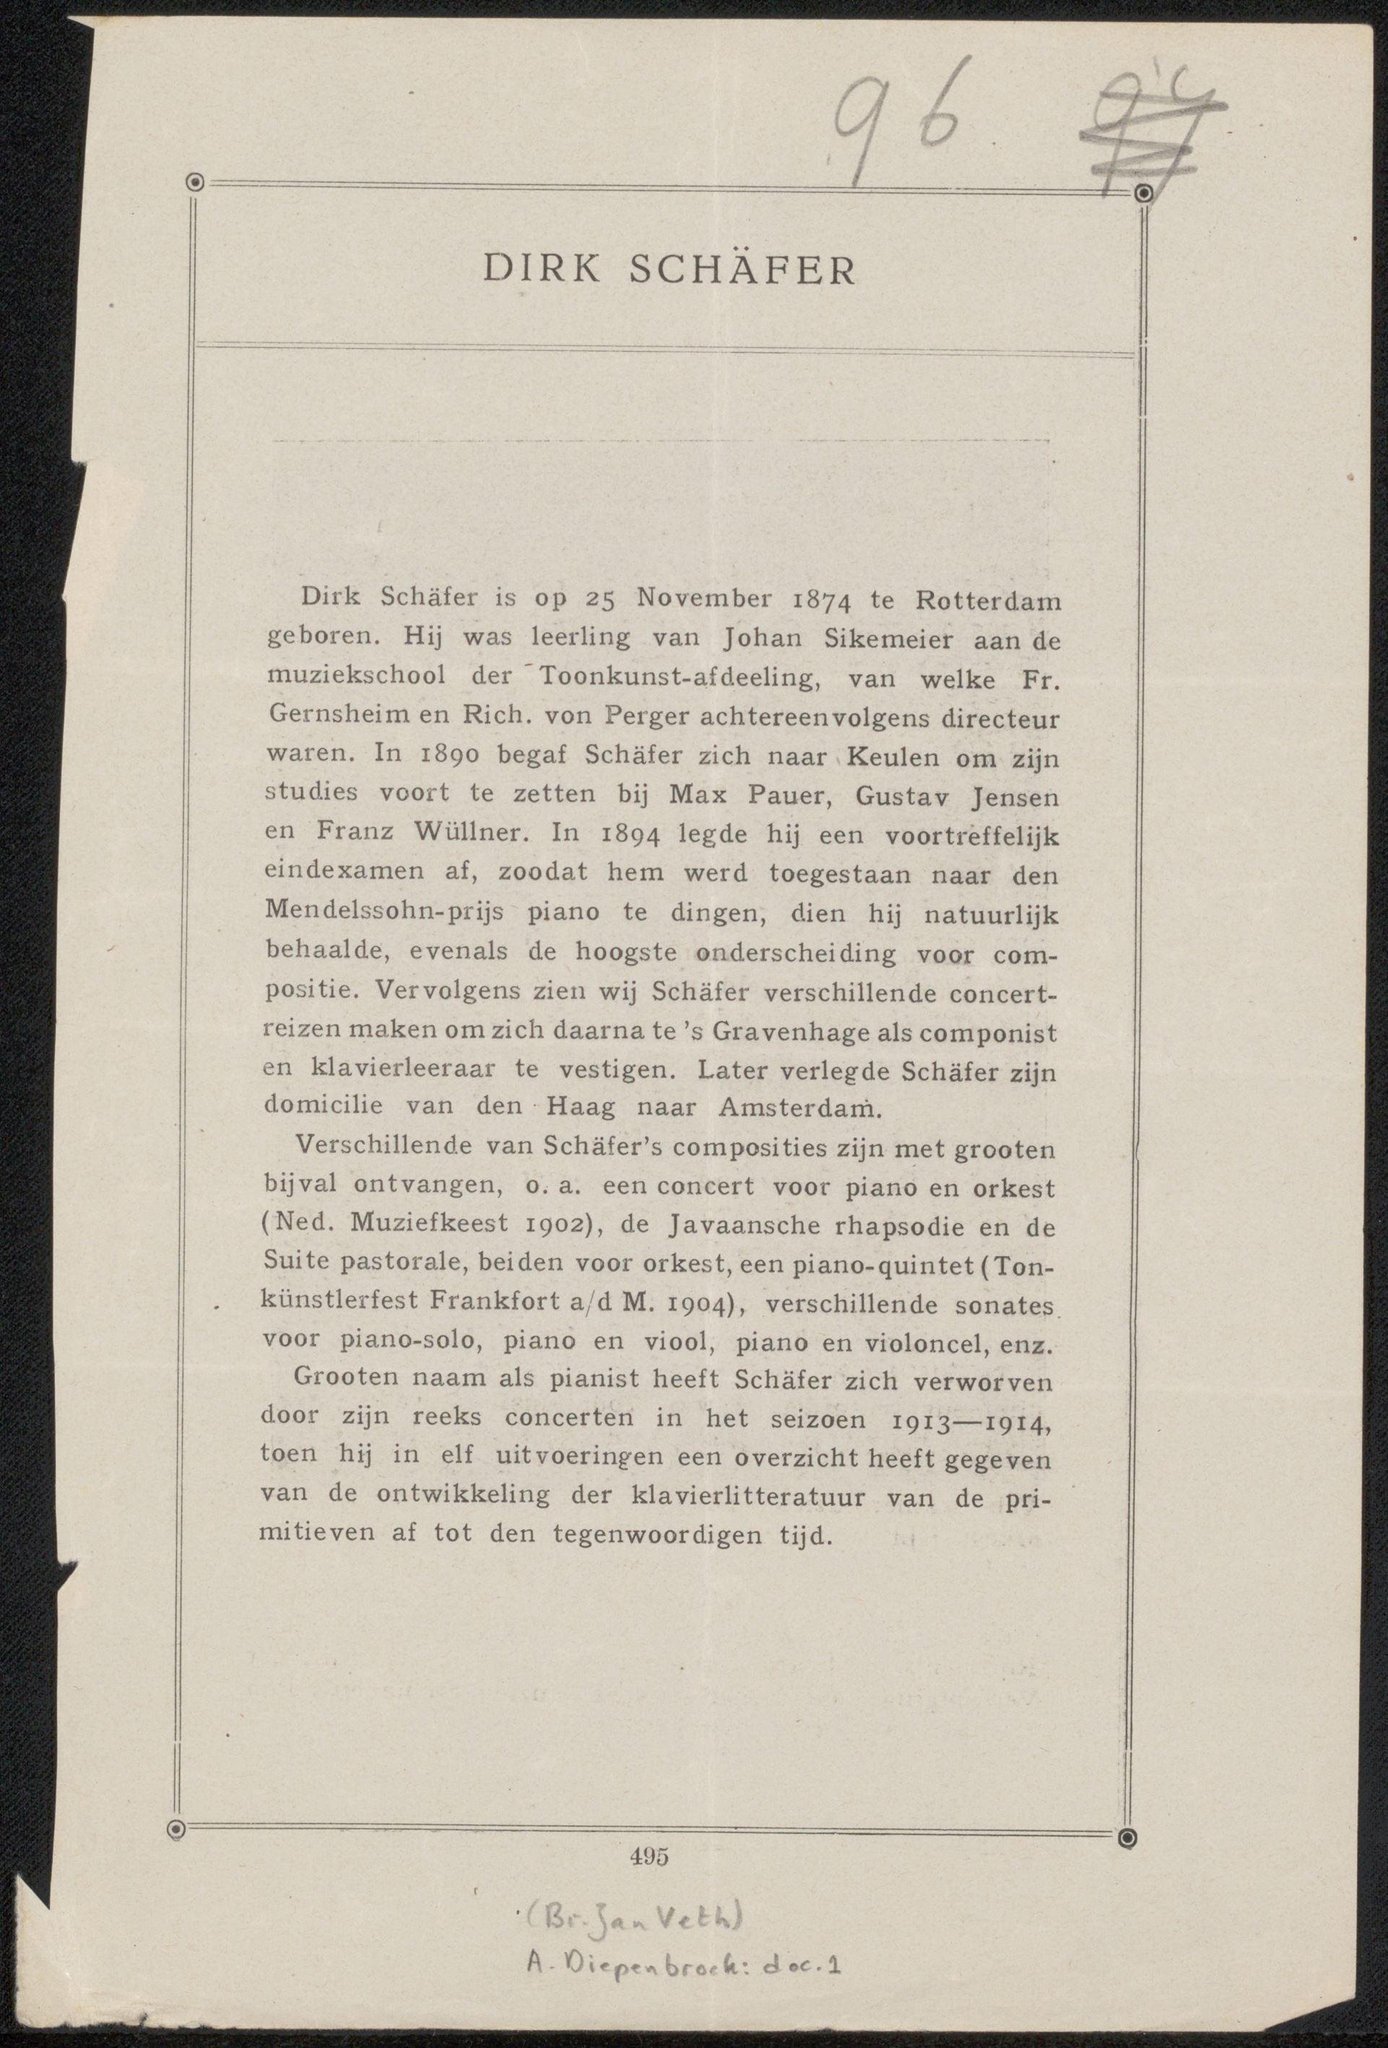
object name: article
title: Artikel uit archief Jan Veth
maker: alphons diepenbrock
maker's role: componist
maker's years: 1862-1921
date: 1919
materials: paper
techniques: printing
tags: dordrecht, painter, print maker, draughtsman, designer, jan veth, music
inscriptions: collector's mark: ‘RPK’